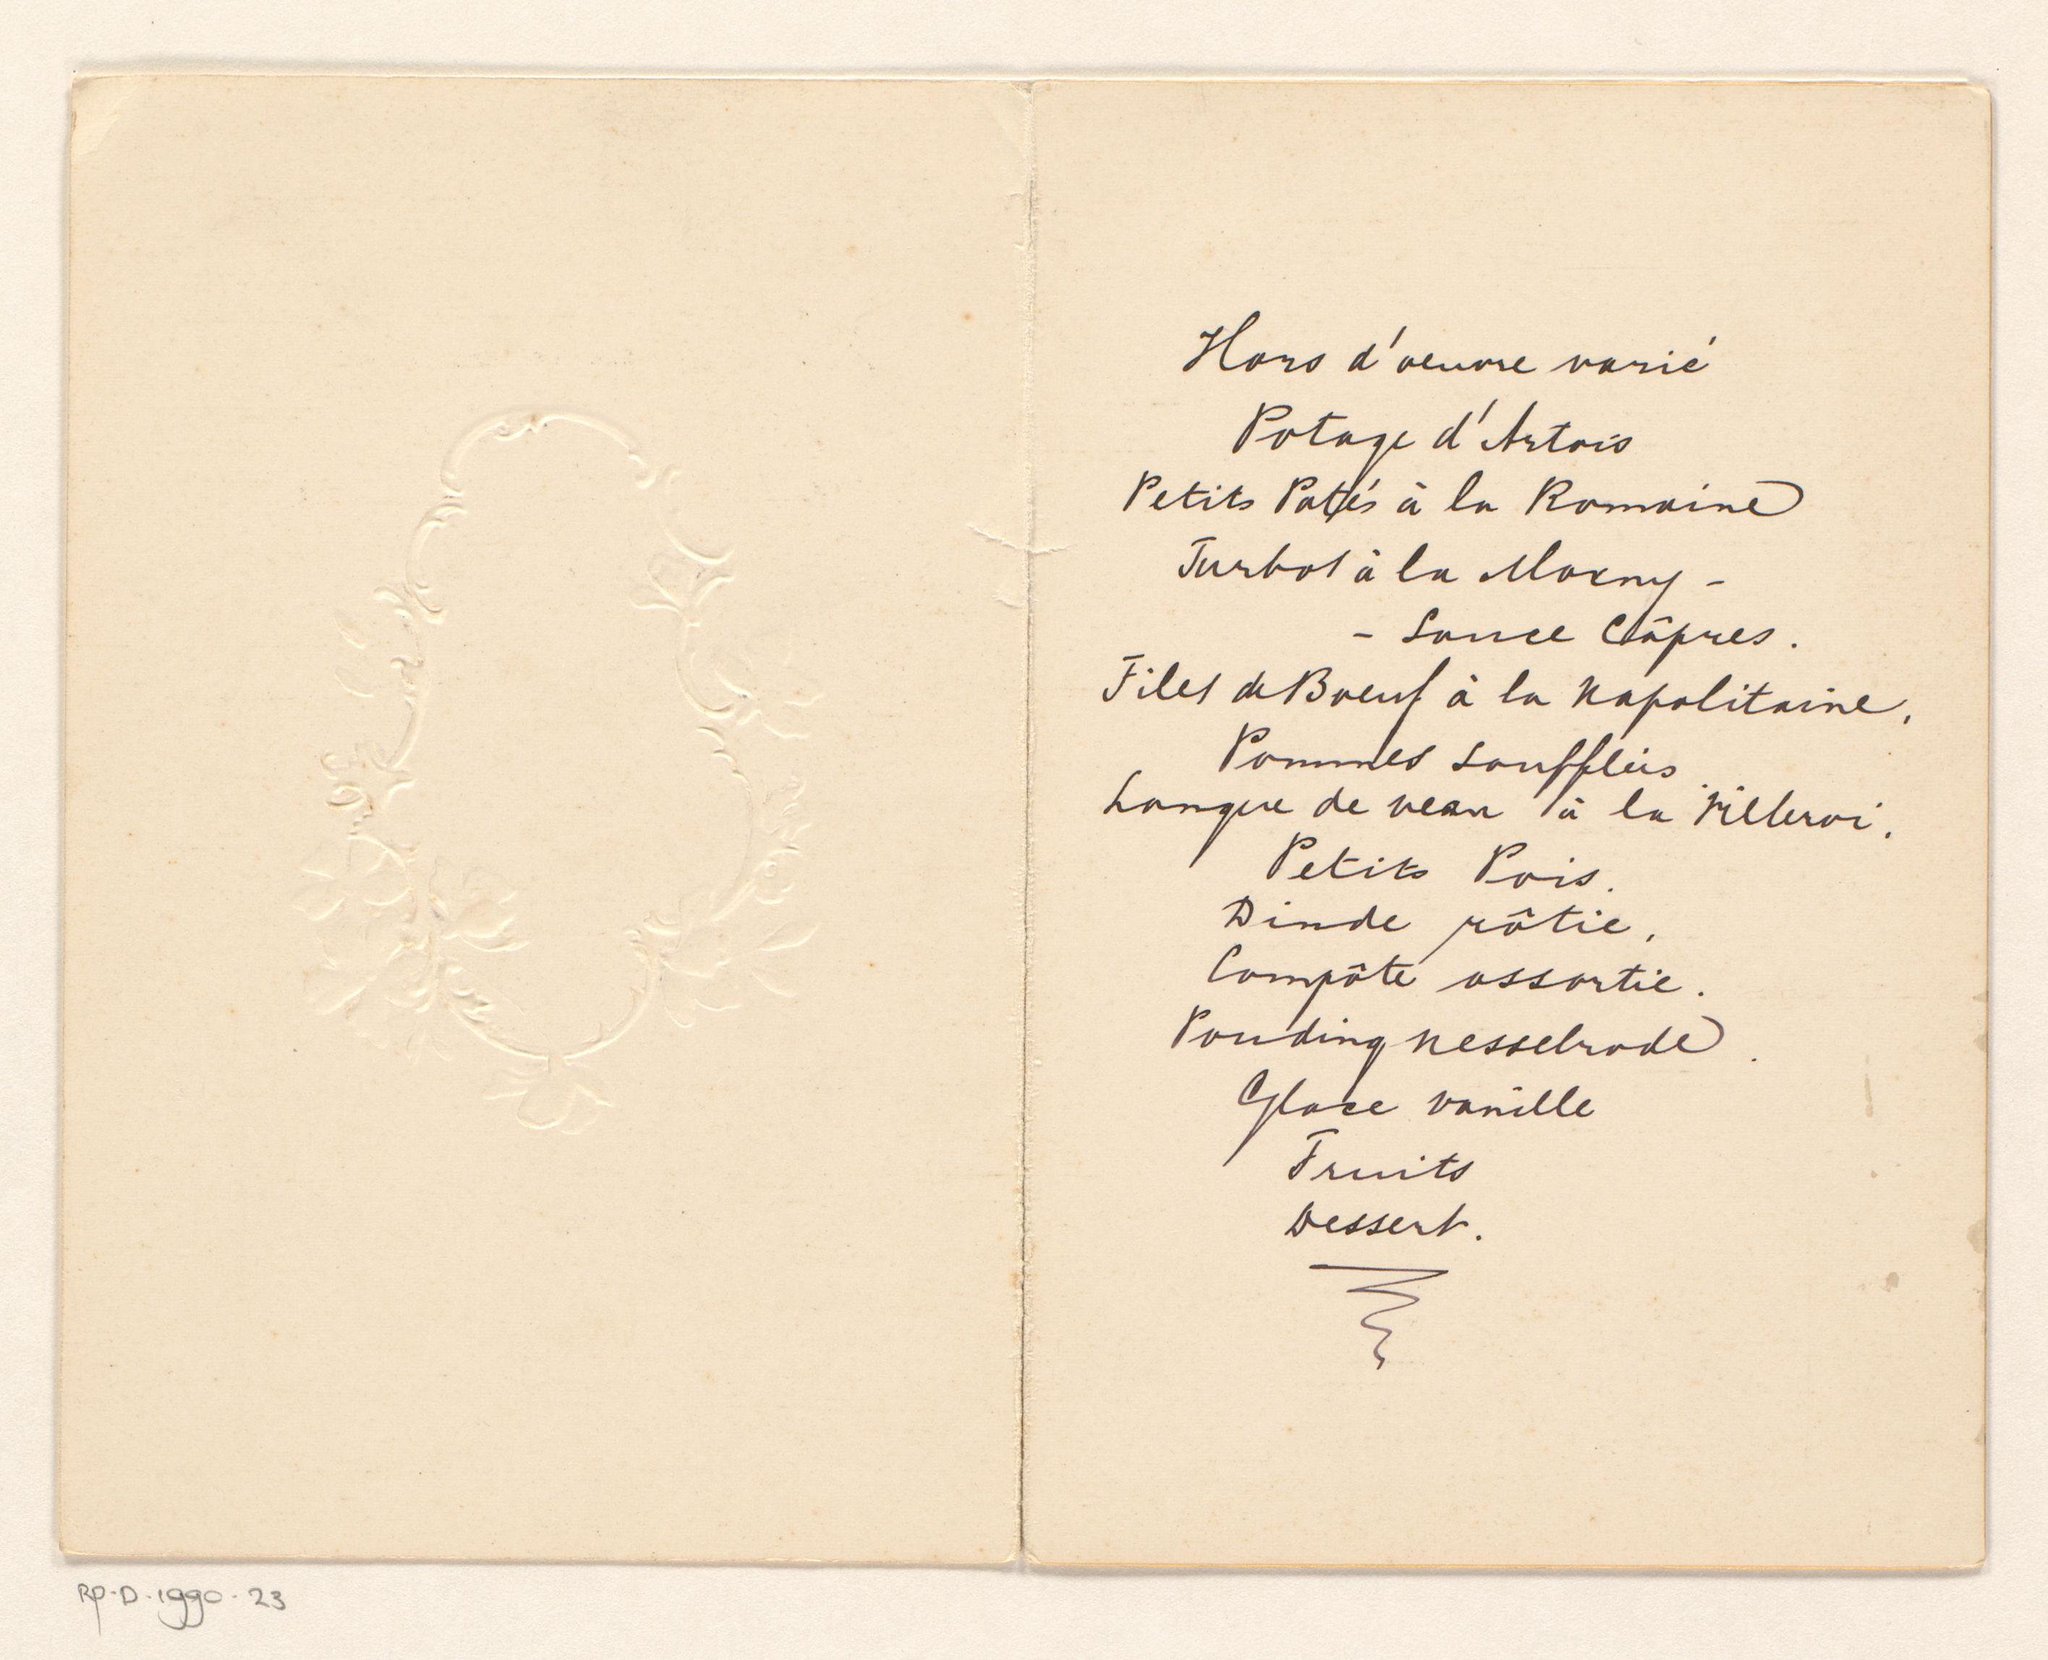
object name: menu, menukaart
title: Menukaart voor een diner op 27 juli 1899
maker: Anonymous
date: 1899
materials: paper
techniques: blind stamped, pen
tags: 43b311(+12)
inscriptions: collector's mark: Lugt 2228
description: Bij gebrek aan gegevens over de vervaardiger is voor de bepaling van de rechten van dit object gebruik gemaakt van de vervaardigingsdatum.